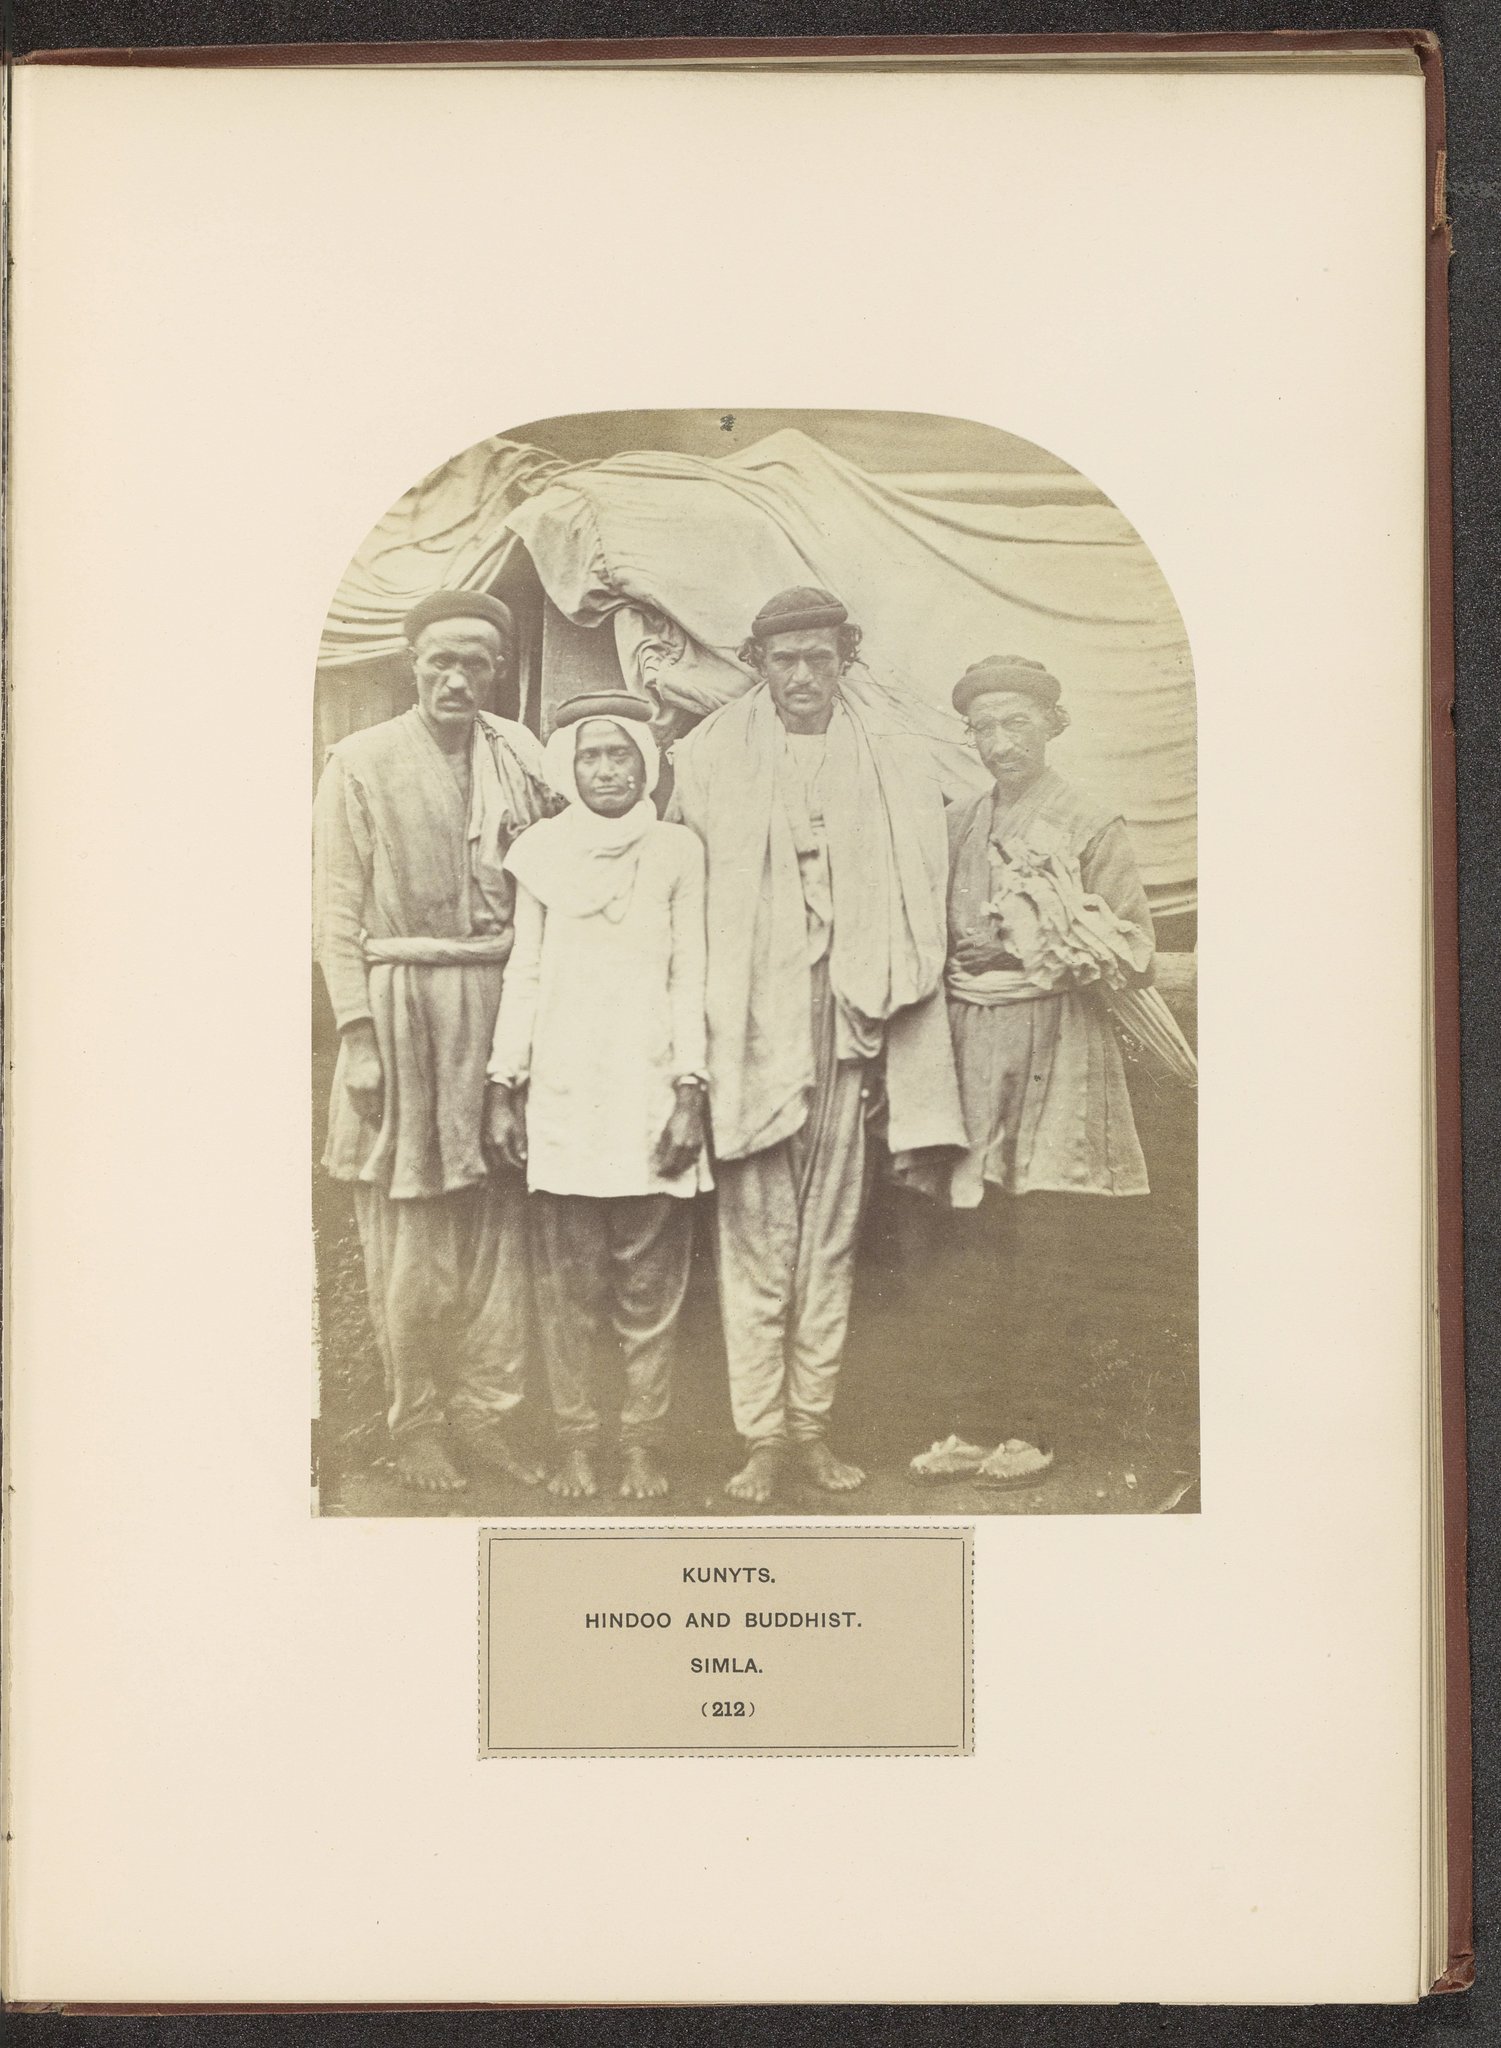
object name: page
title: Portrait of four people from the Kanet community of Shimla, Himachal Pradesh, India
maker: Anonymous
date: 1859-1869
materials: photographic support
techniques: albumen print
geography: shimla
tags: human races; peoples; nationalities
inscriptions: number: ‘(212)’, inscription: ‘KUNYTS./ HINDOO AND BUDDHIST./ SIMLA.’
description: De Kanet-gemeenschap is ook bekend als Kunait.